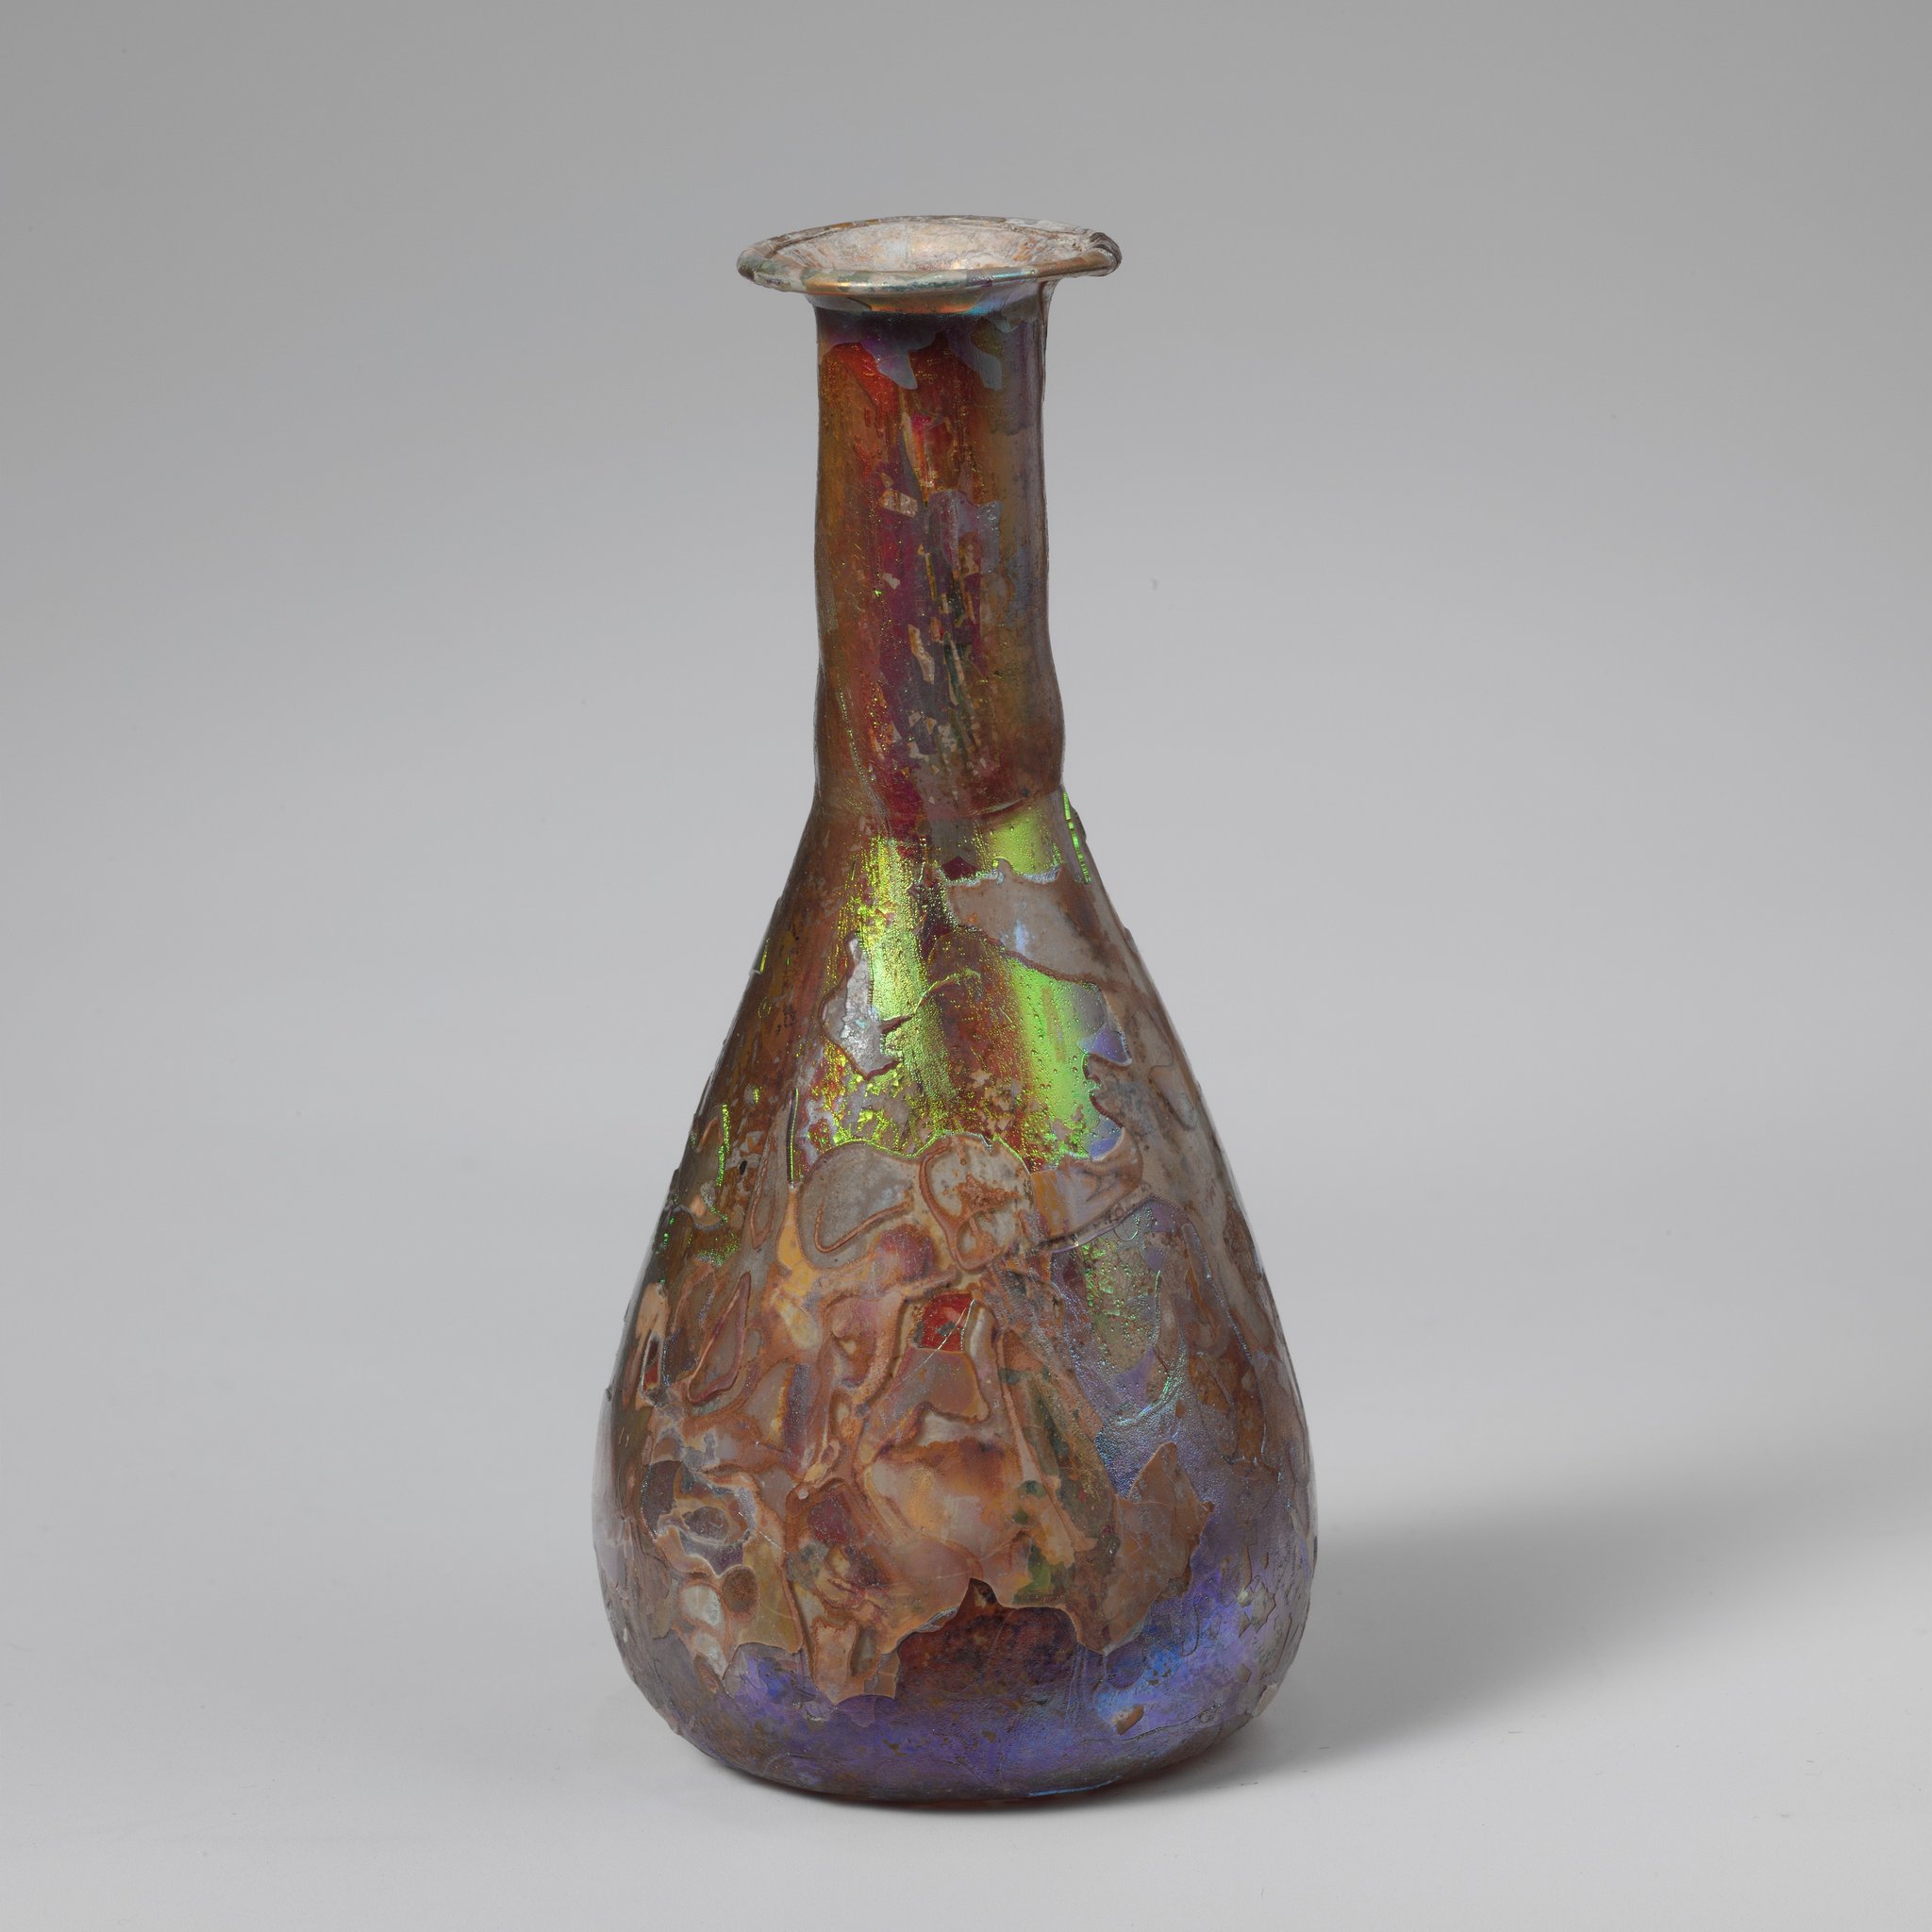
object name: perfume bottle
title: Glass perfume bottle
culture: roman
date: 1-200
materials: glass